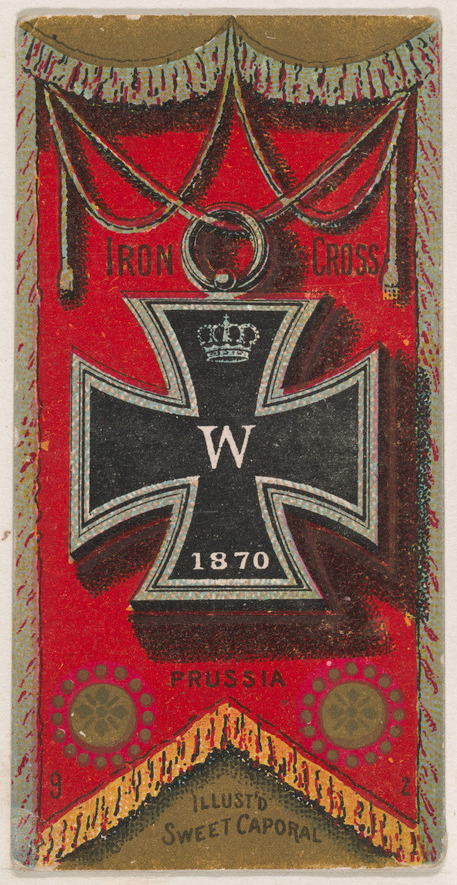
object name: print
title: Iron Cross, Prussia, from the Military Series (N224) issued by Kinney Tobacco Company to promote Sweet Caporal Cigarettes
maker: kinney brothers tobacco company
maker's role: publisher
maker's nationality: american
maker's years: 1869-2011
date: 1888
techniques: color lithograph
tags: insignia